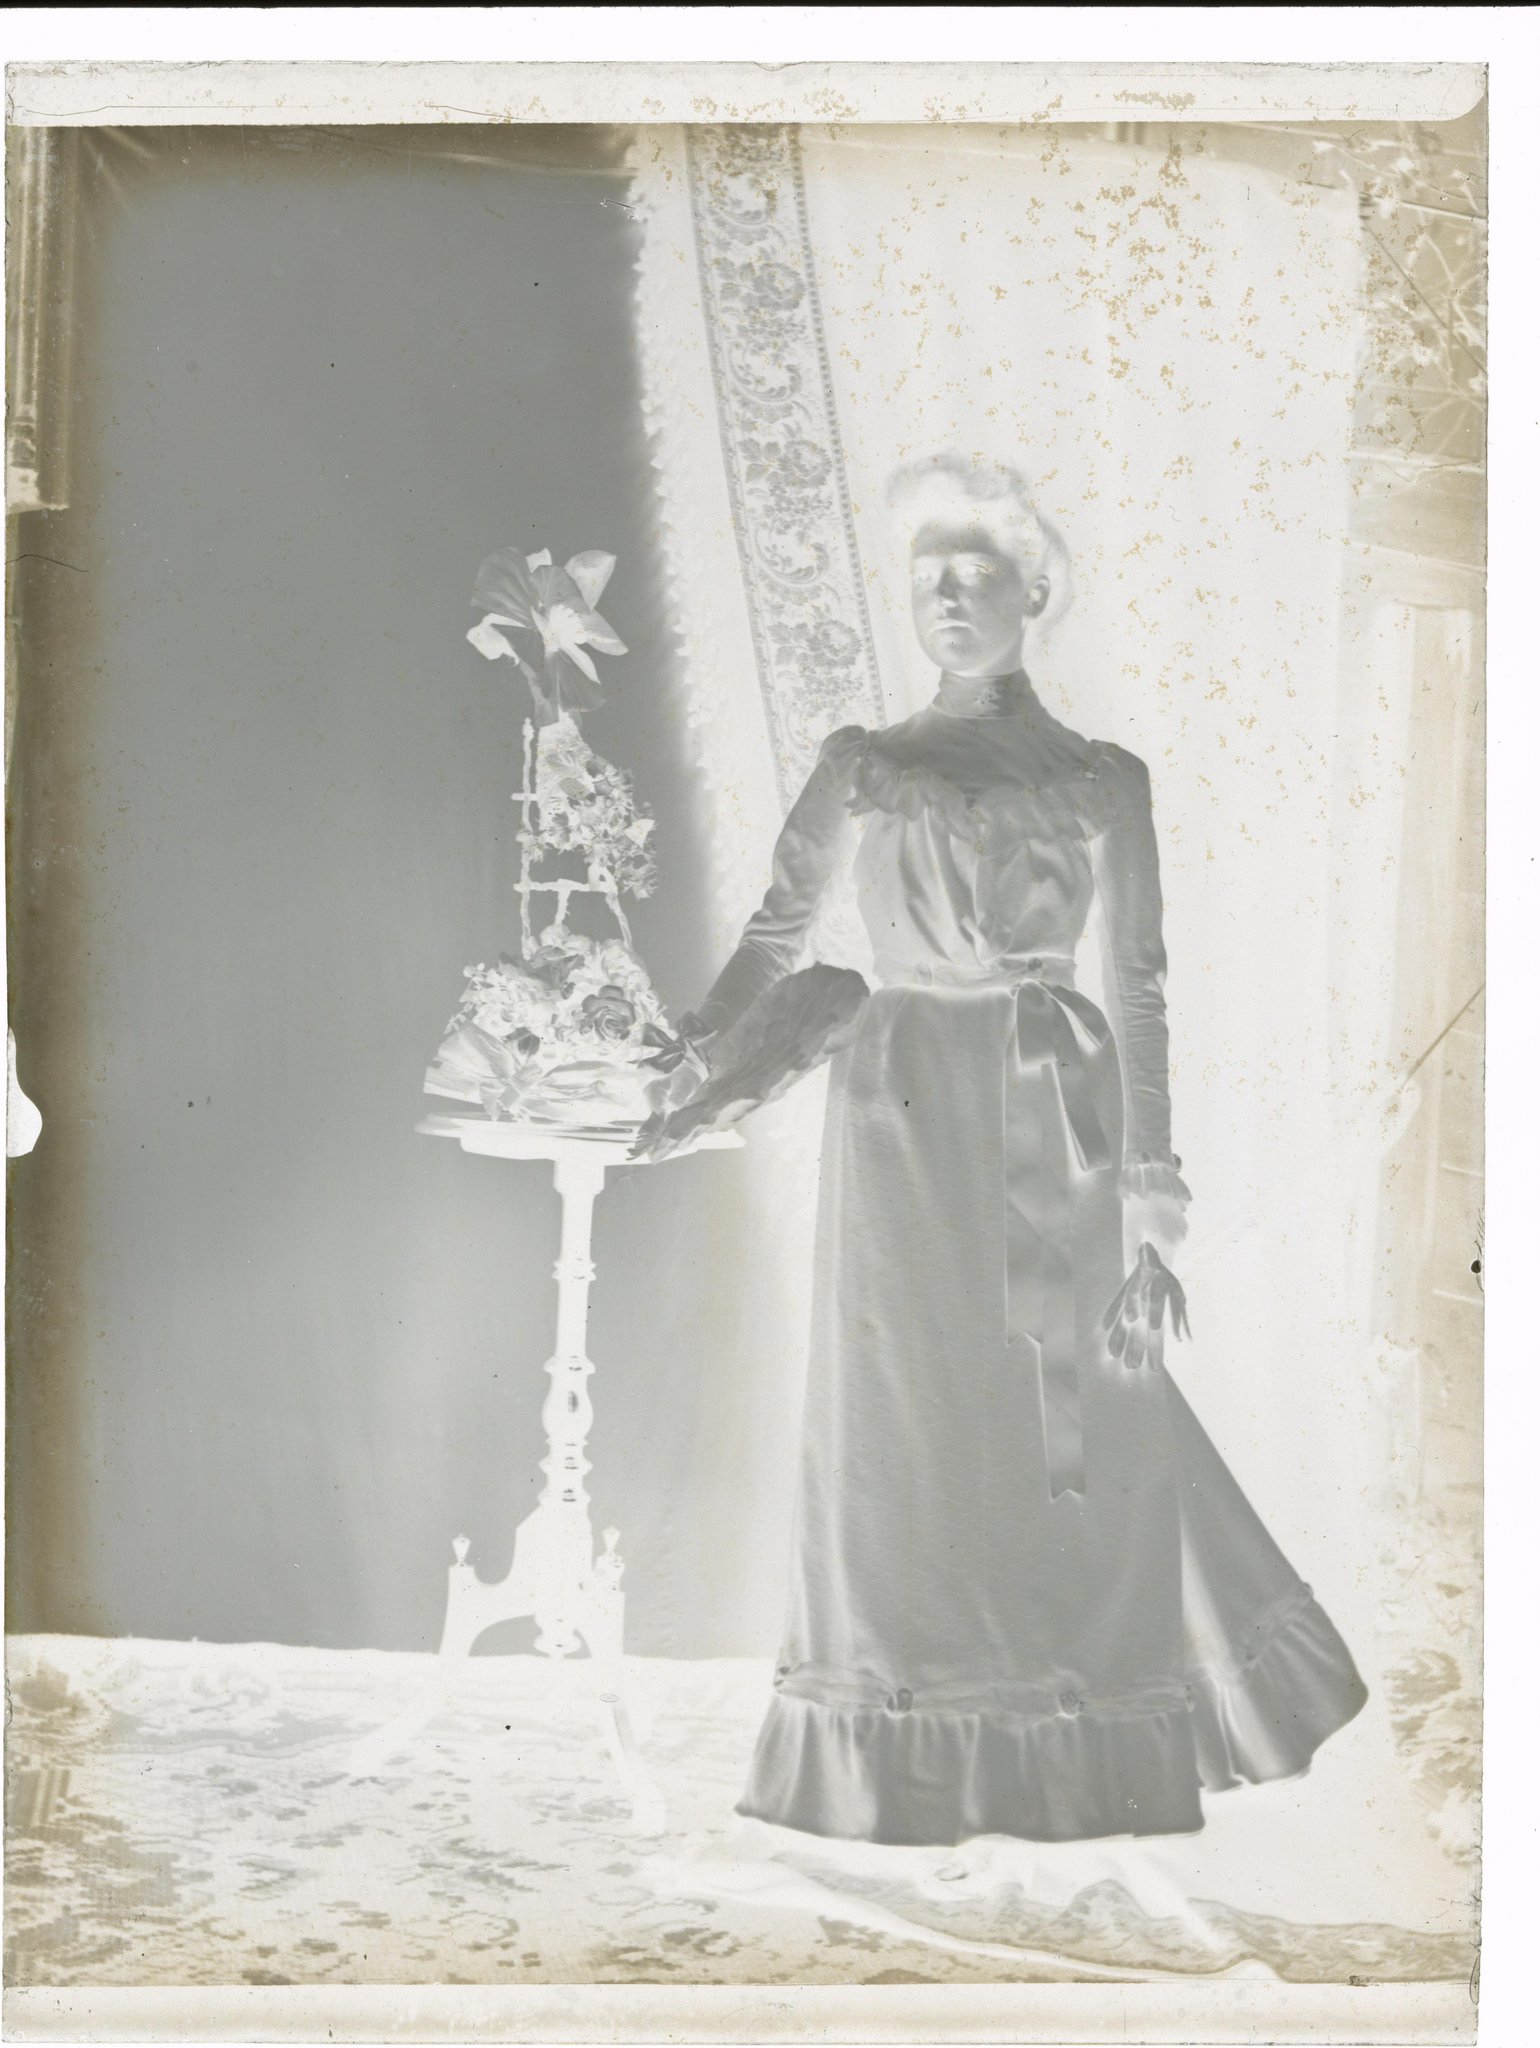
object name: glasnegatief, glasplaatnegatief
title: Portret van een onbekende vrouw naast een bijzettafel met bloemstuk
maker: Anonymous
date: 1907-1935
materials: glass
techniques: gelatin glass negative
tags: cut flowers; nosegay, bunch of flowers, historical persons not known by name